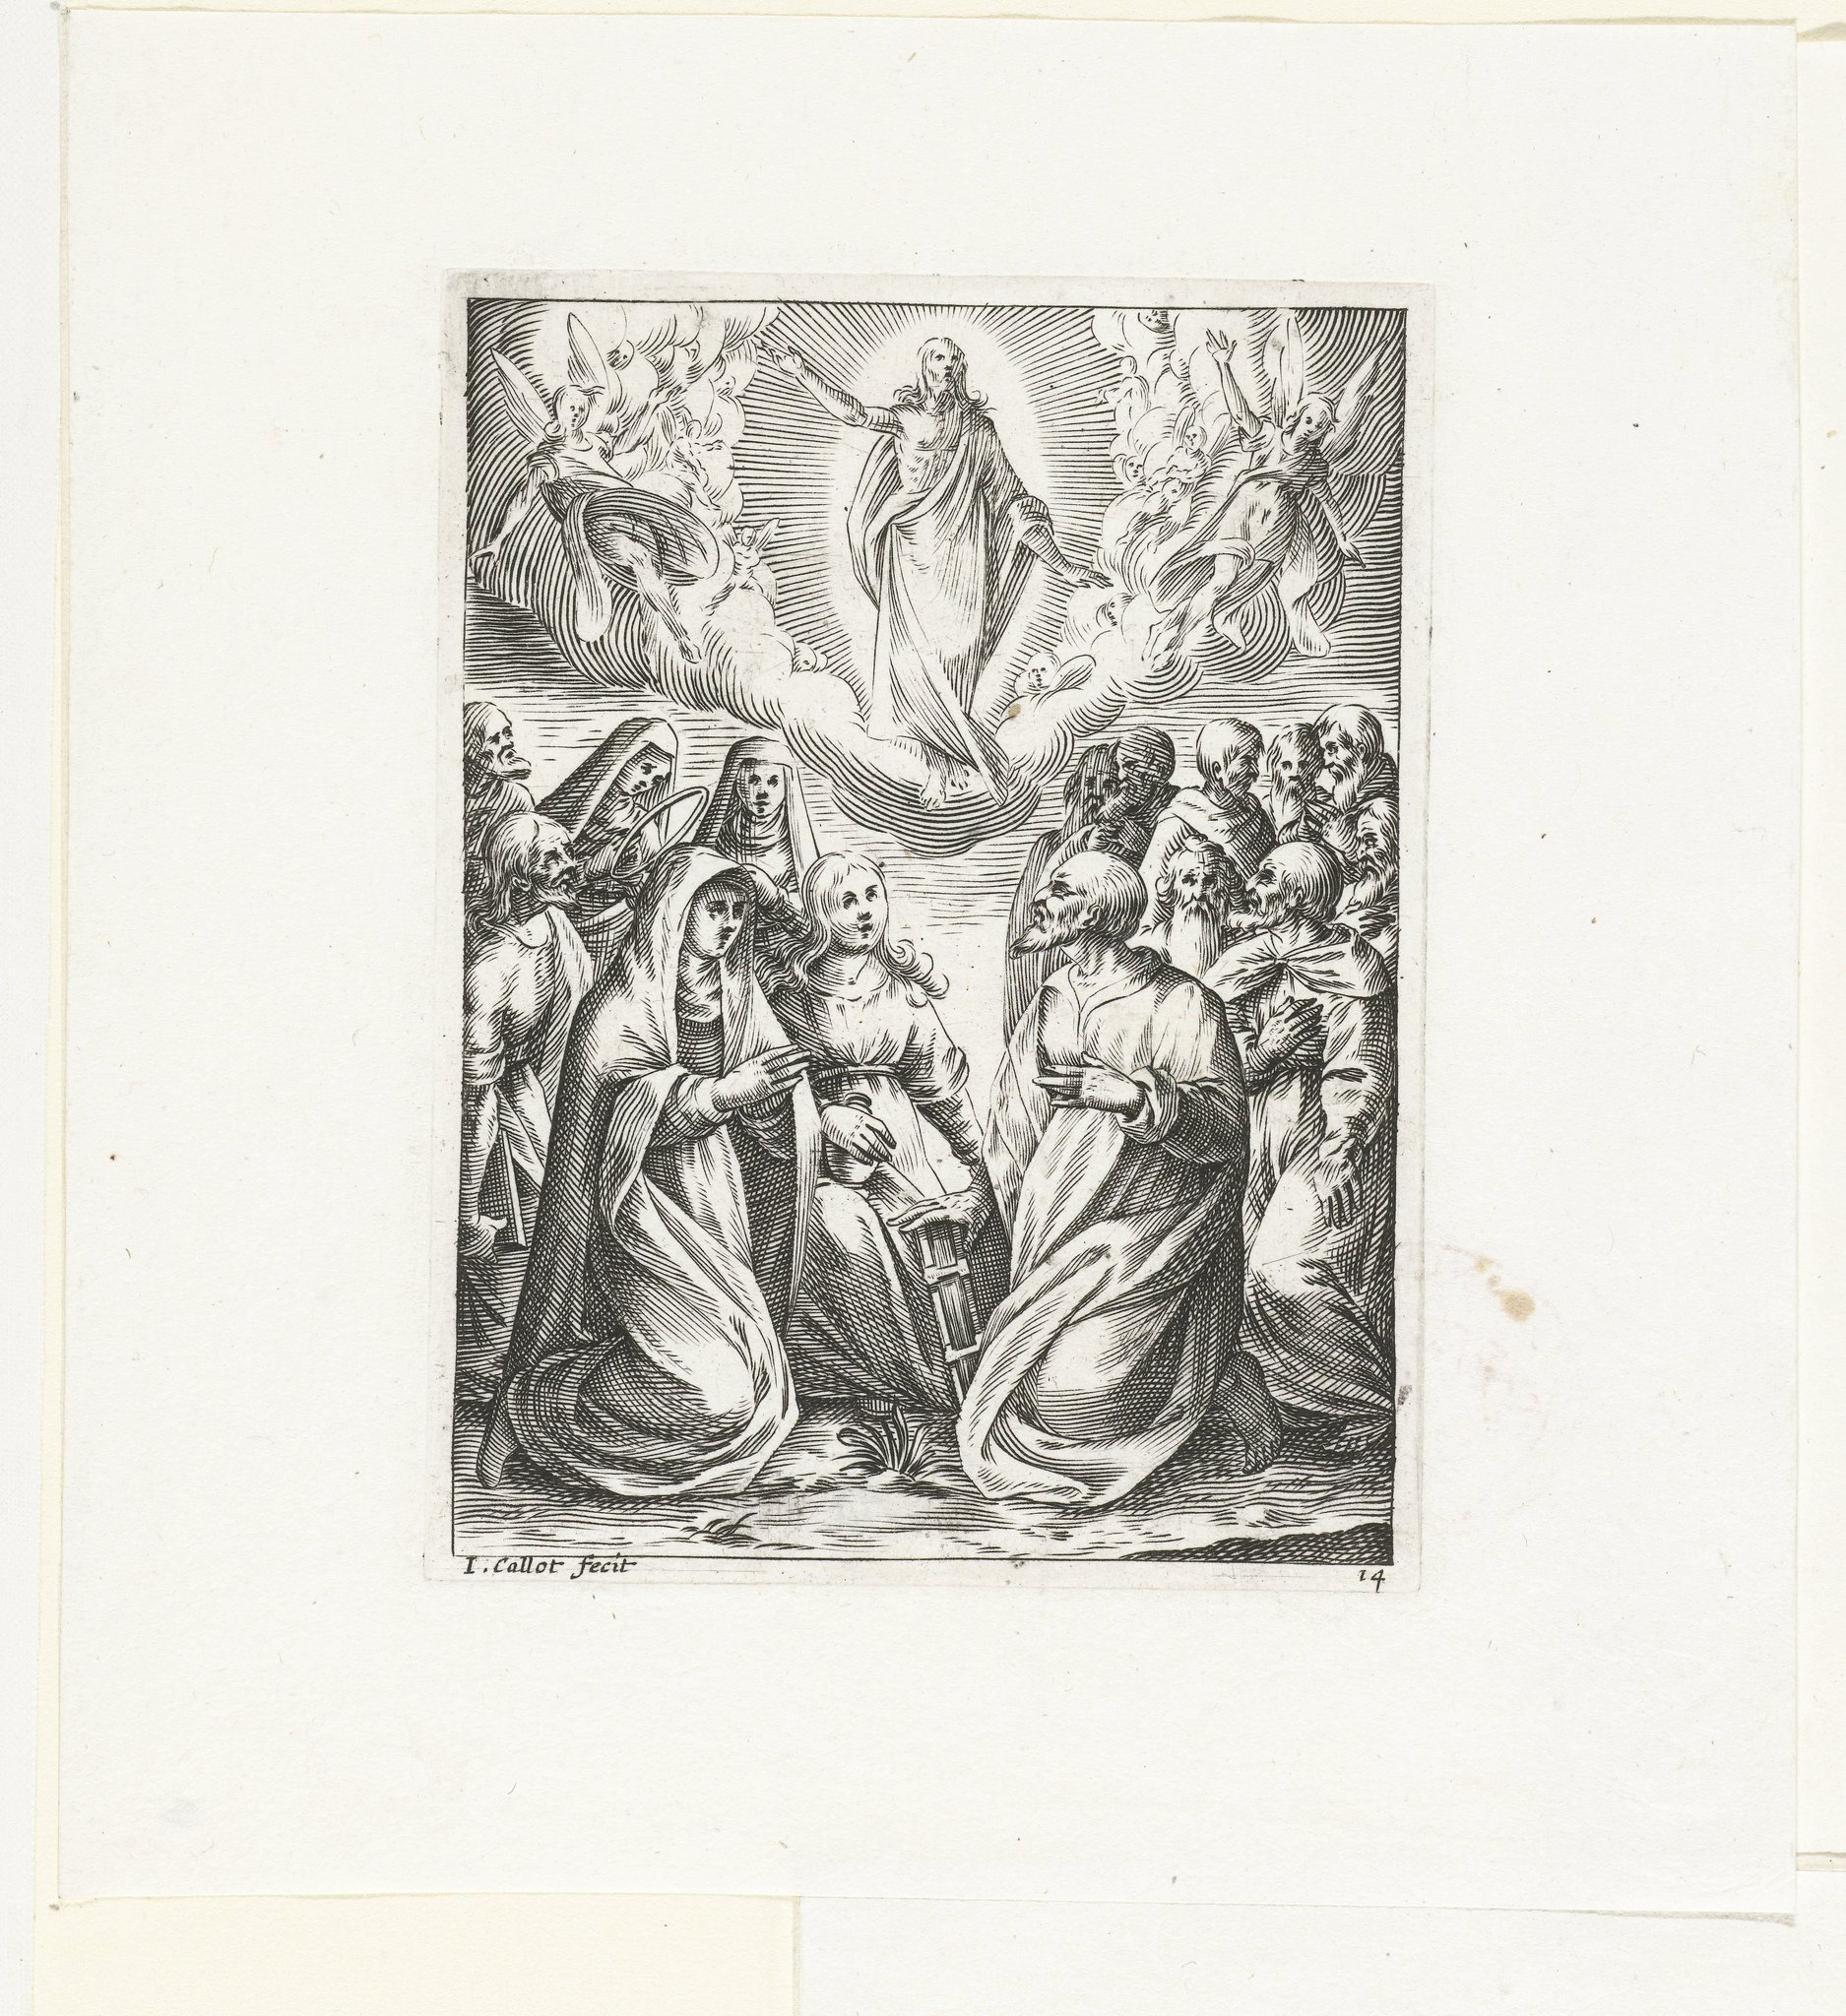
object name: print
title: Hemelvaart van Christus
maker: jacques callot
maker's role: draughtsman, print maker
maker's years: 1592-1635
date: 1608-1611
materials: paper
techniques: engraving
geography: rome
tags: christ ascends into heaven; apostles (and mary) beneath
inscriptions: collector's mark: Lugt 240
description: Christus rijst in een wolk met engelen ten hemel, terwijl de apostelen, Maria, Maria Magdalena en nog twee heilige vrouwen op aarde knielen. Deze prent is onderdeel van (de tweede staat van) een serie van 29 voorstellingen van schilderijen en sculpturen in kerken te Rome, genummerd 1-16 en 1-13. (De eerste staat van deze serie, waarin de prenten ongenummerd zijn, behelst ook een titelprent).